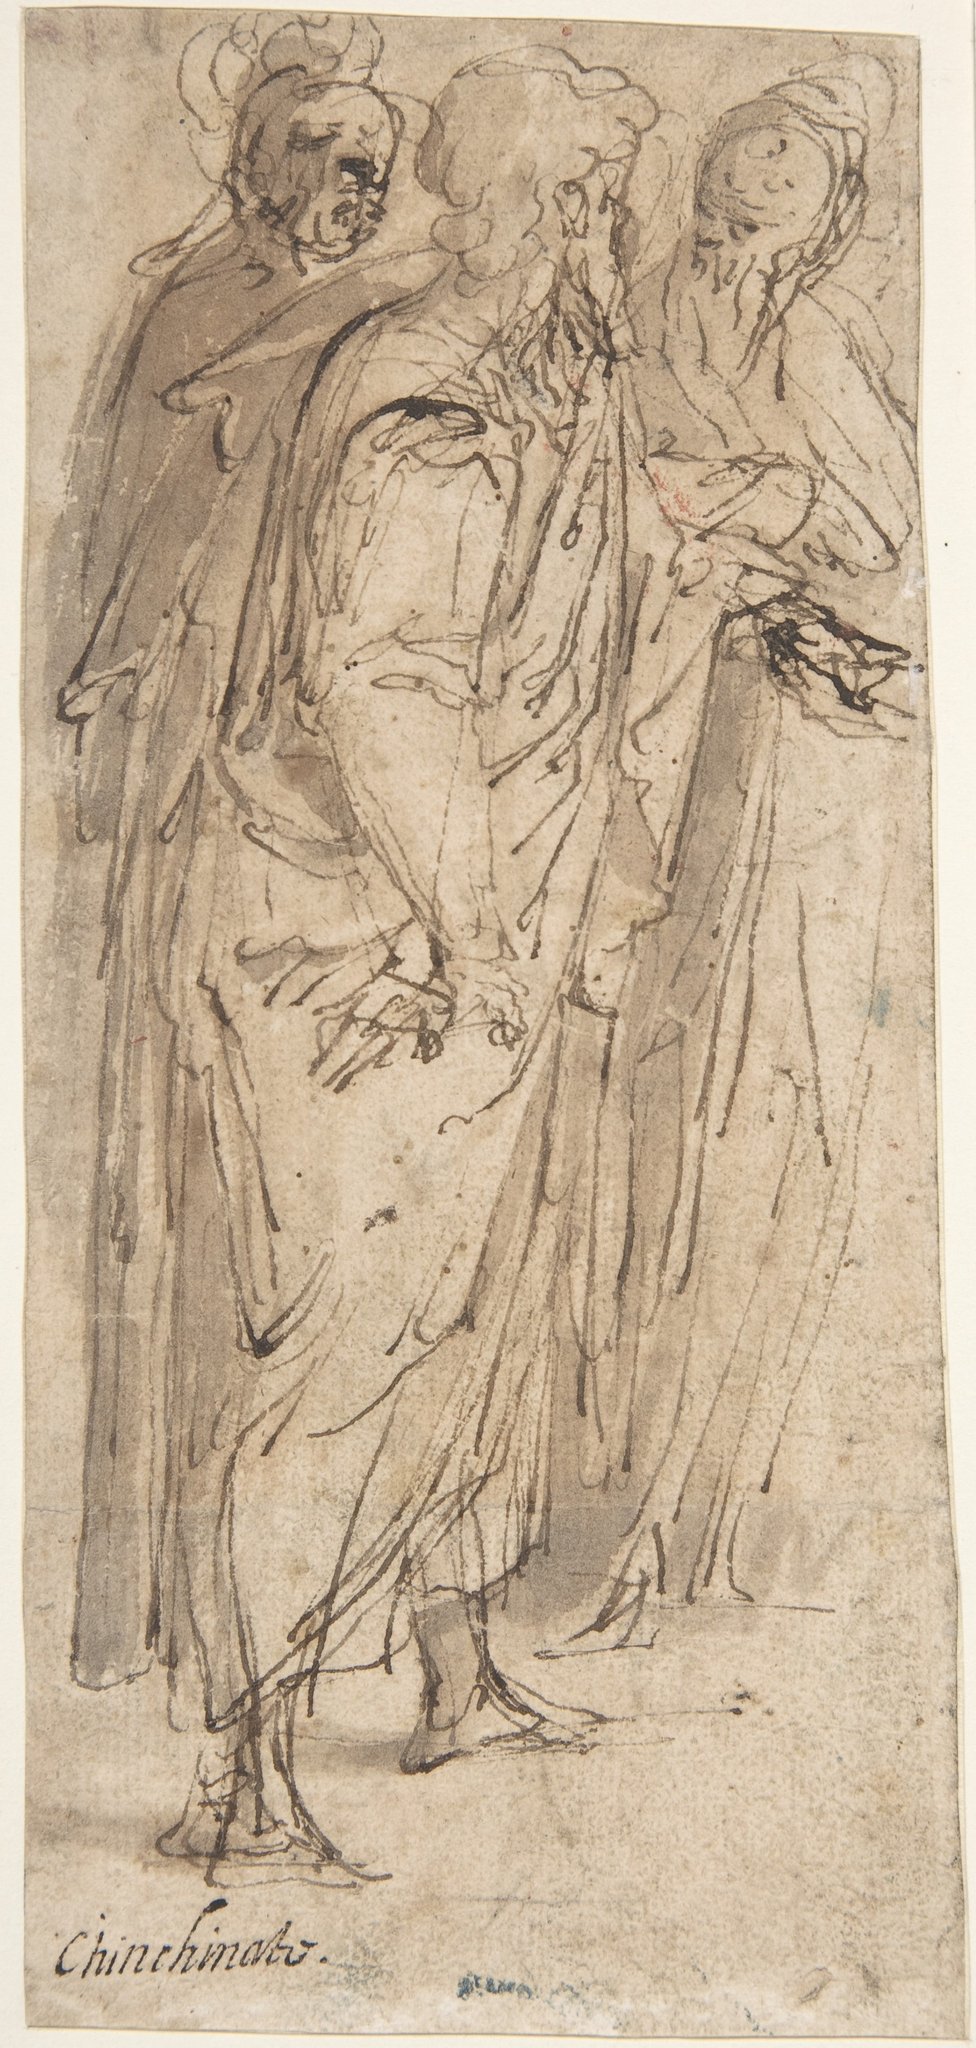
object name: drawing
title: Three Standing Male Figures (recto); Two Standing Male Figures (verso)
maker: romulo cincinnato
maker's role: artist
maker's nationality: italian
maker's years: 1540-1597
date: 1502-1593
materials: chalk, ink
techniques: brush, pen, wash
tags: men